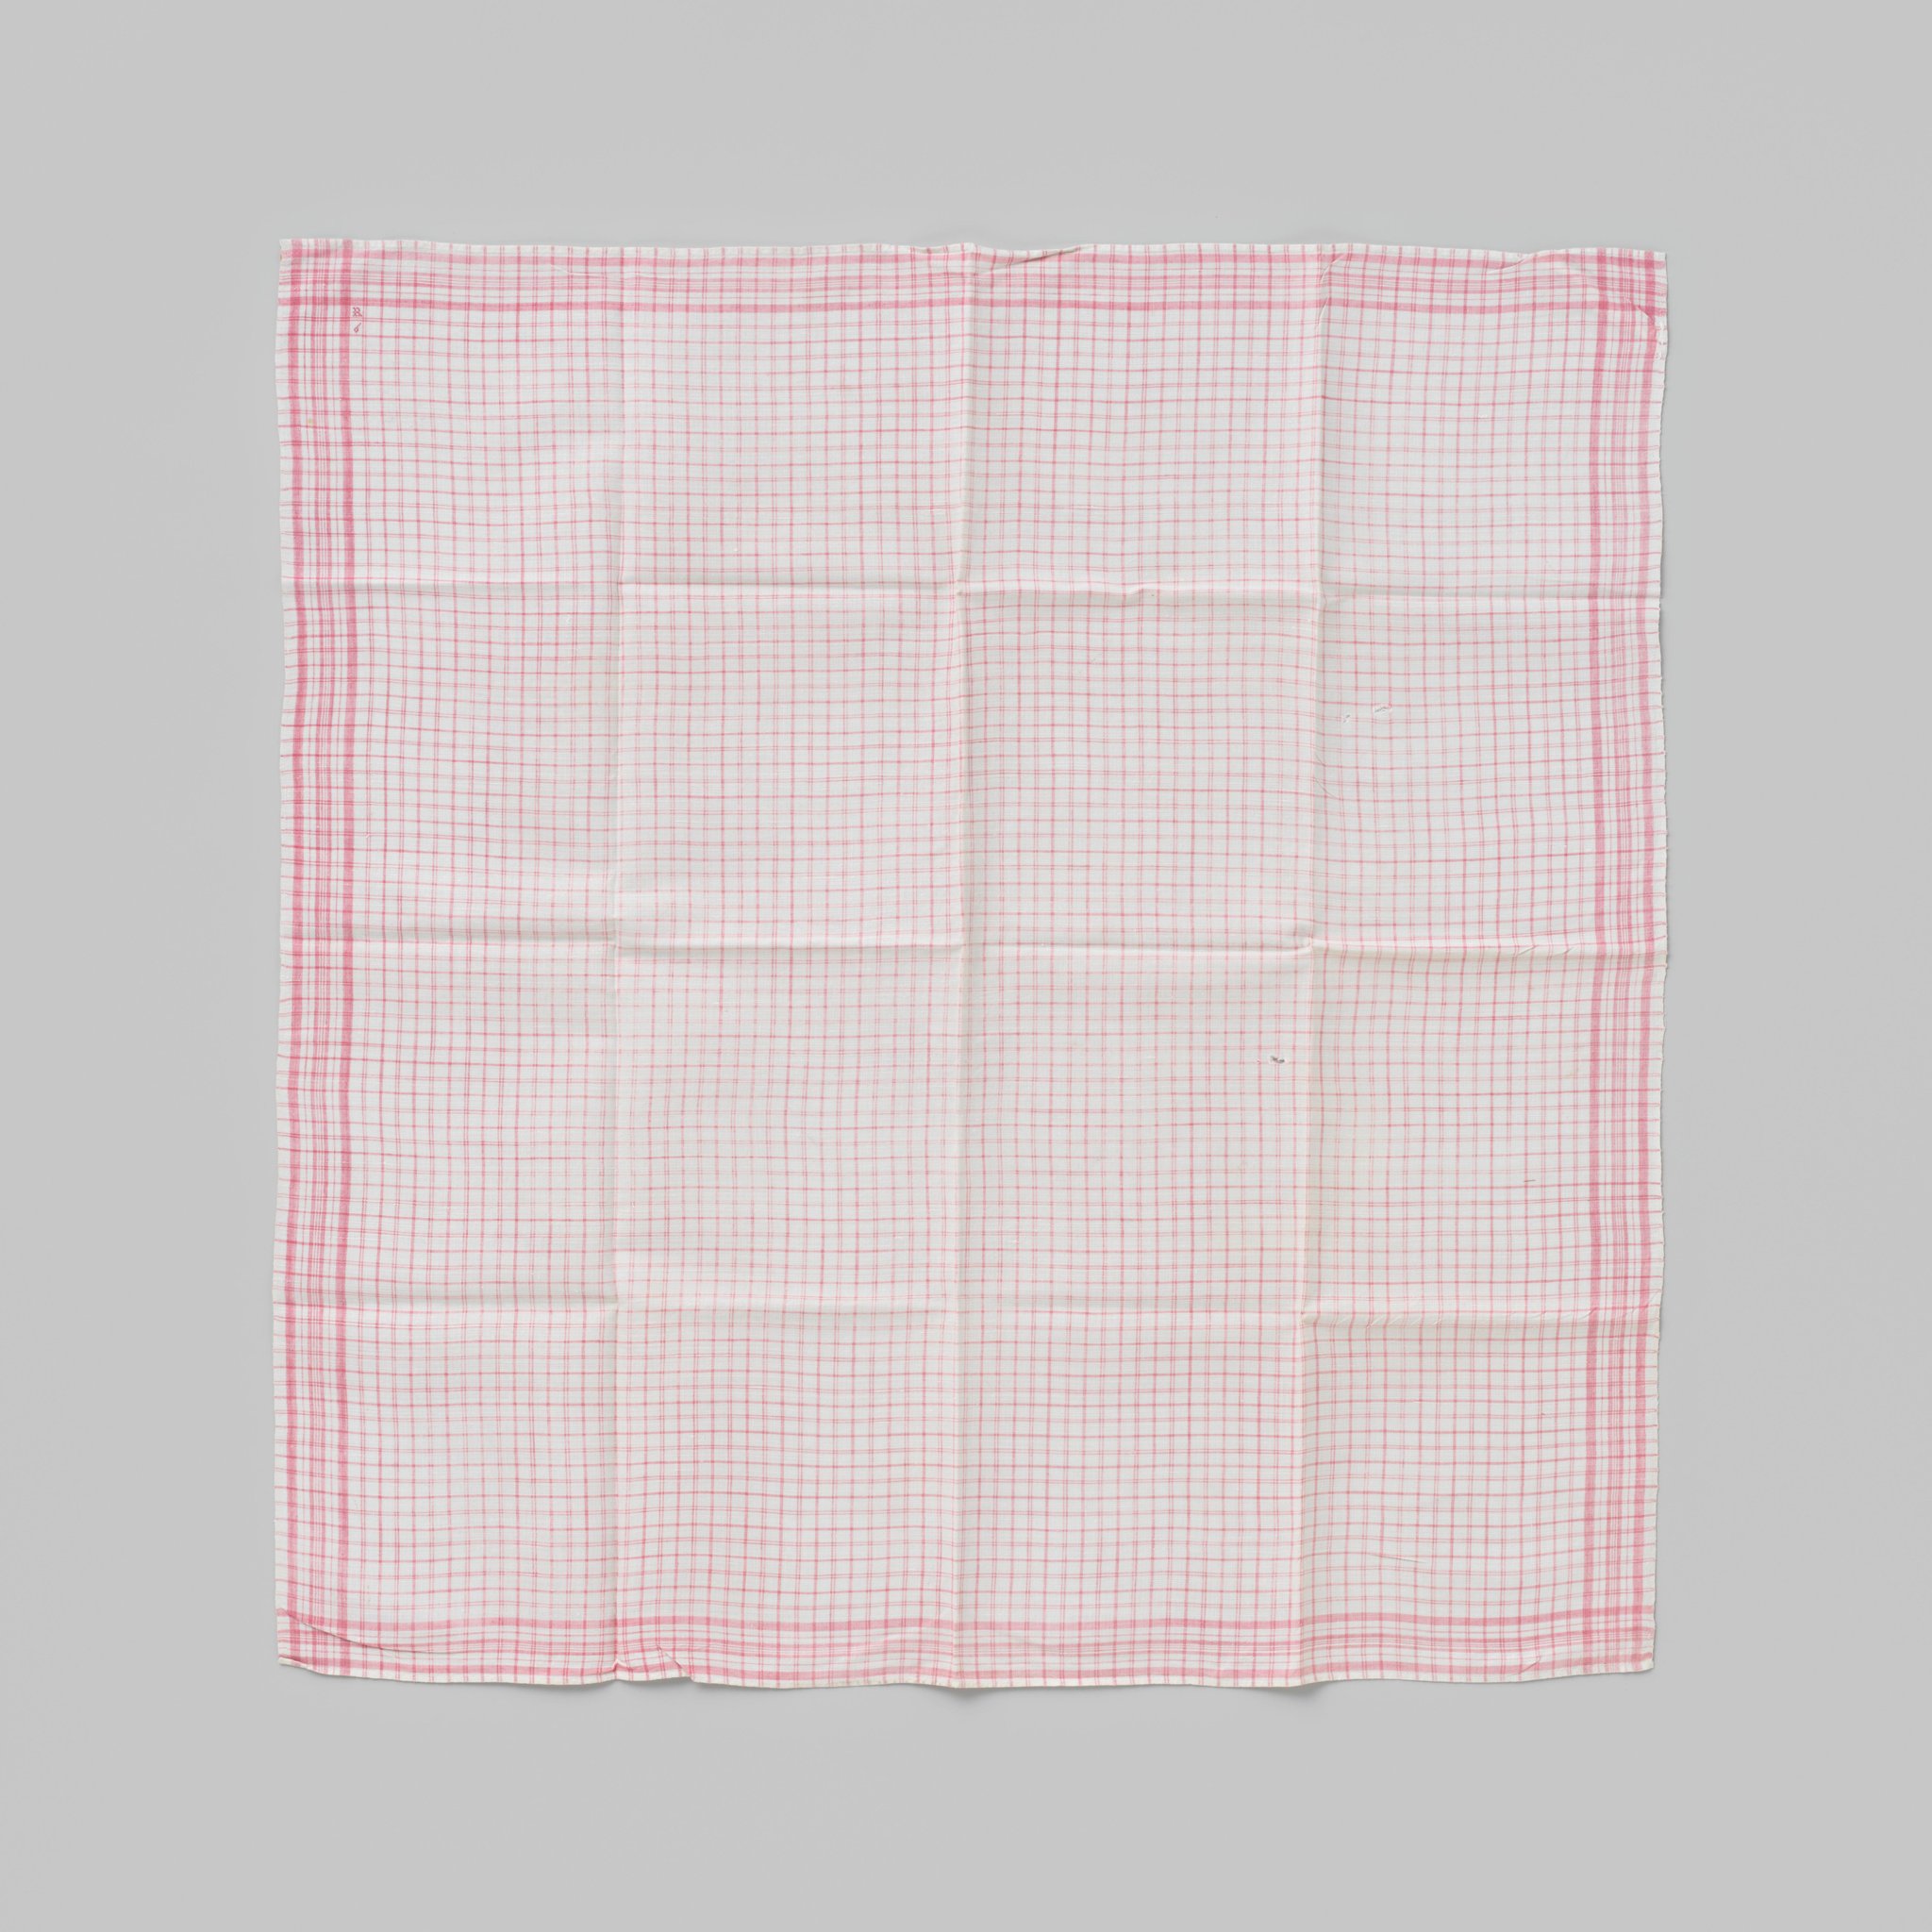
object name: kitchen towel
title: Theedoek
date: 1831-1860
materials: linen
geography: netherlands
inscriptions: mark: ‘R6’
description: Roodgeruite theedoek van linnen. Merk R6.